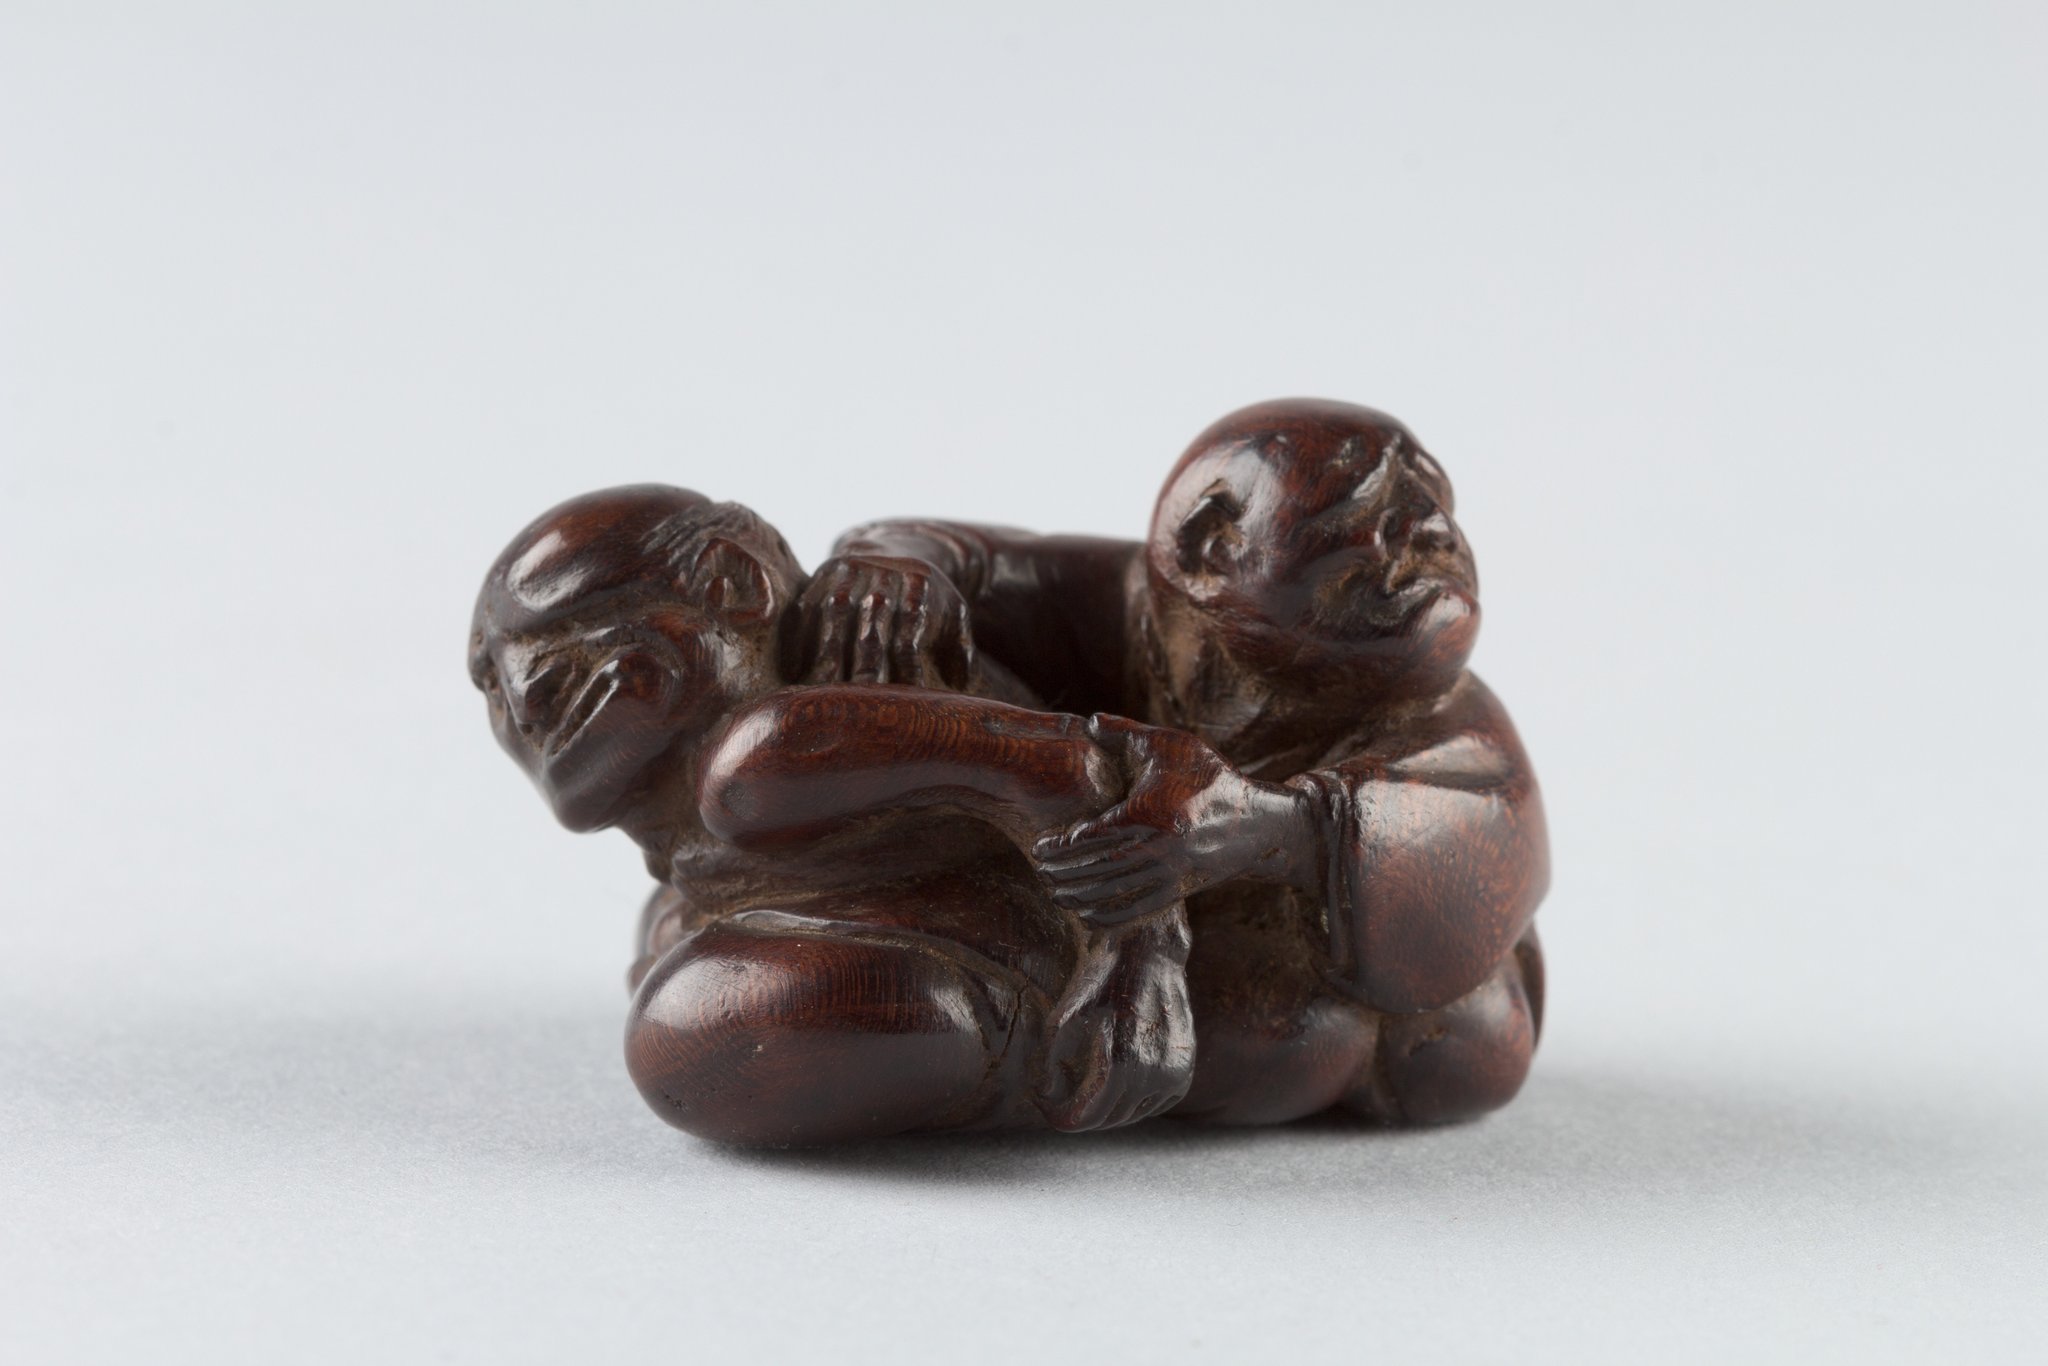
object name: netsuke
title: Netsuke of Two Figures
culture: japanese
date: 1801-1900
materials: wood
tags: men